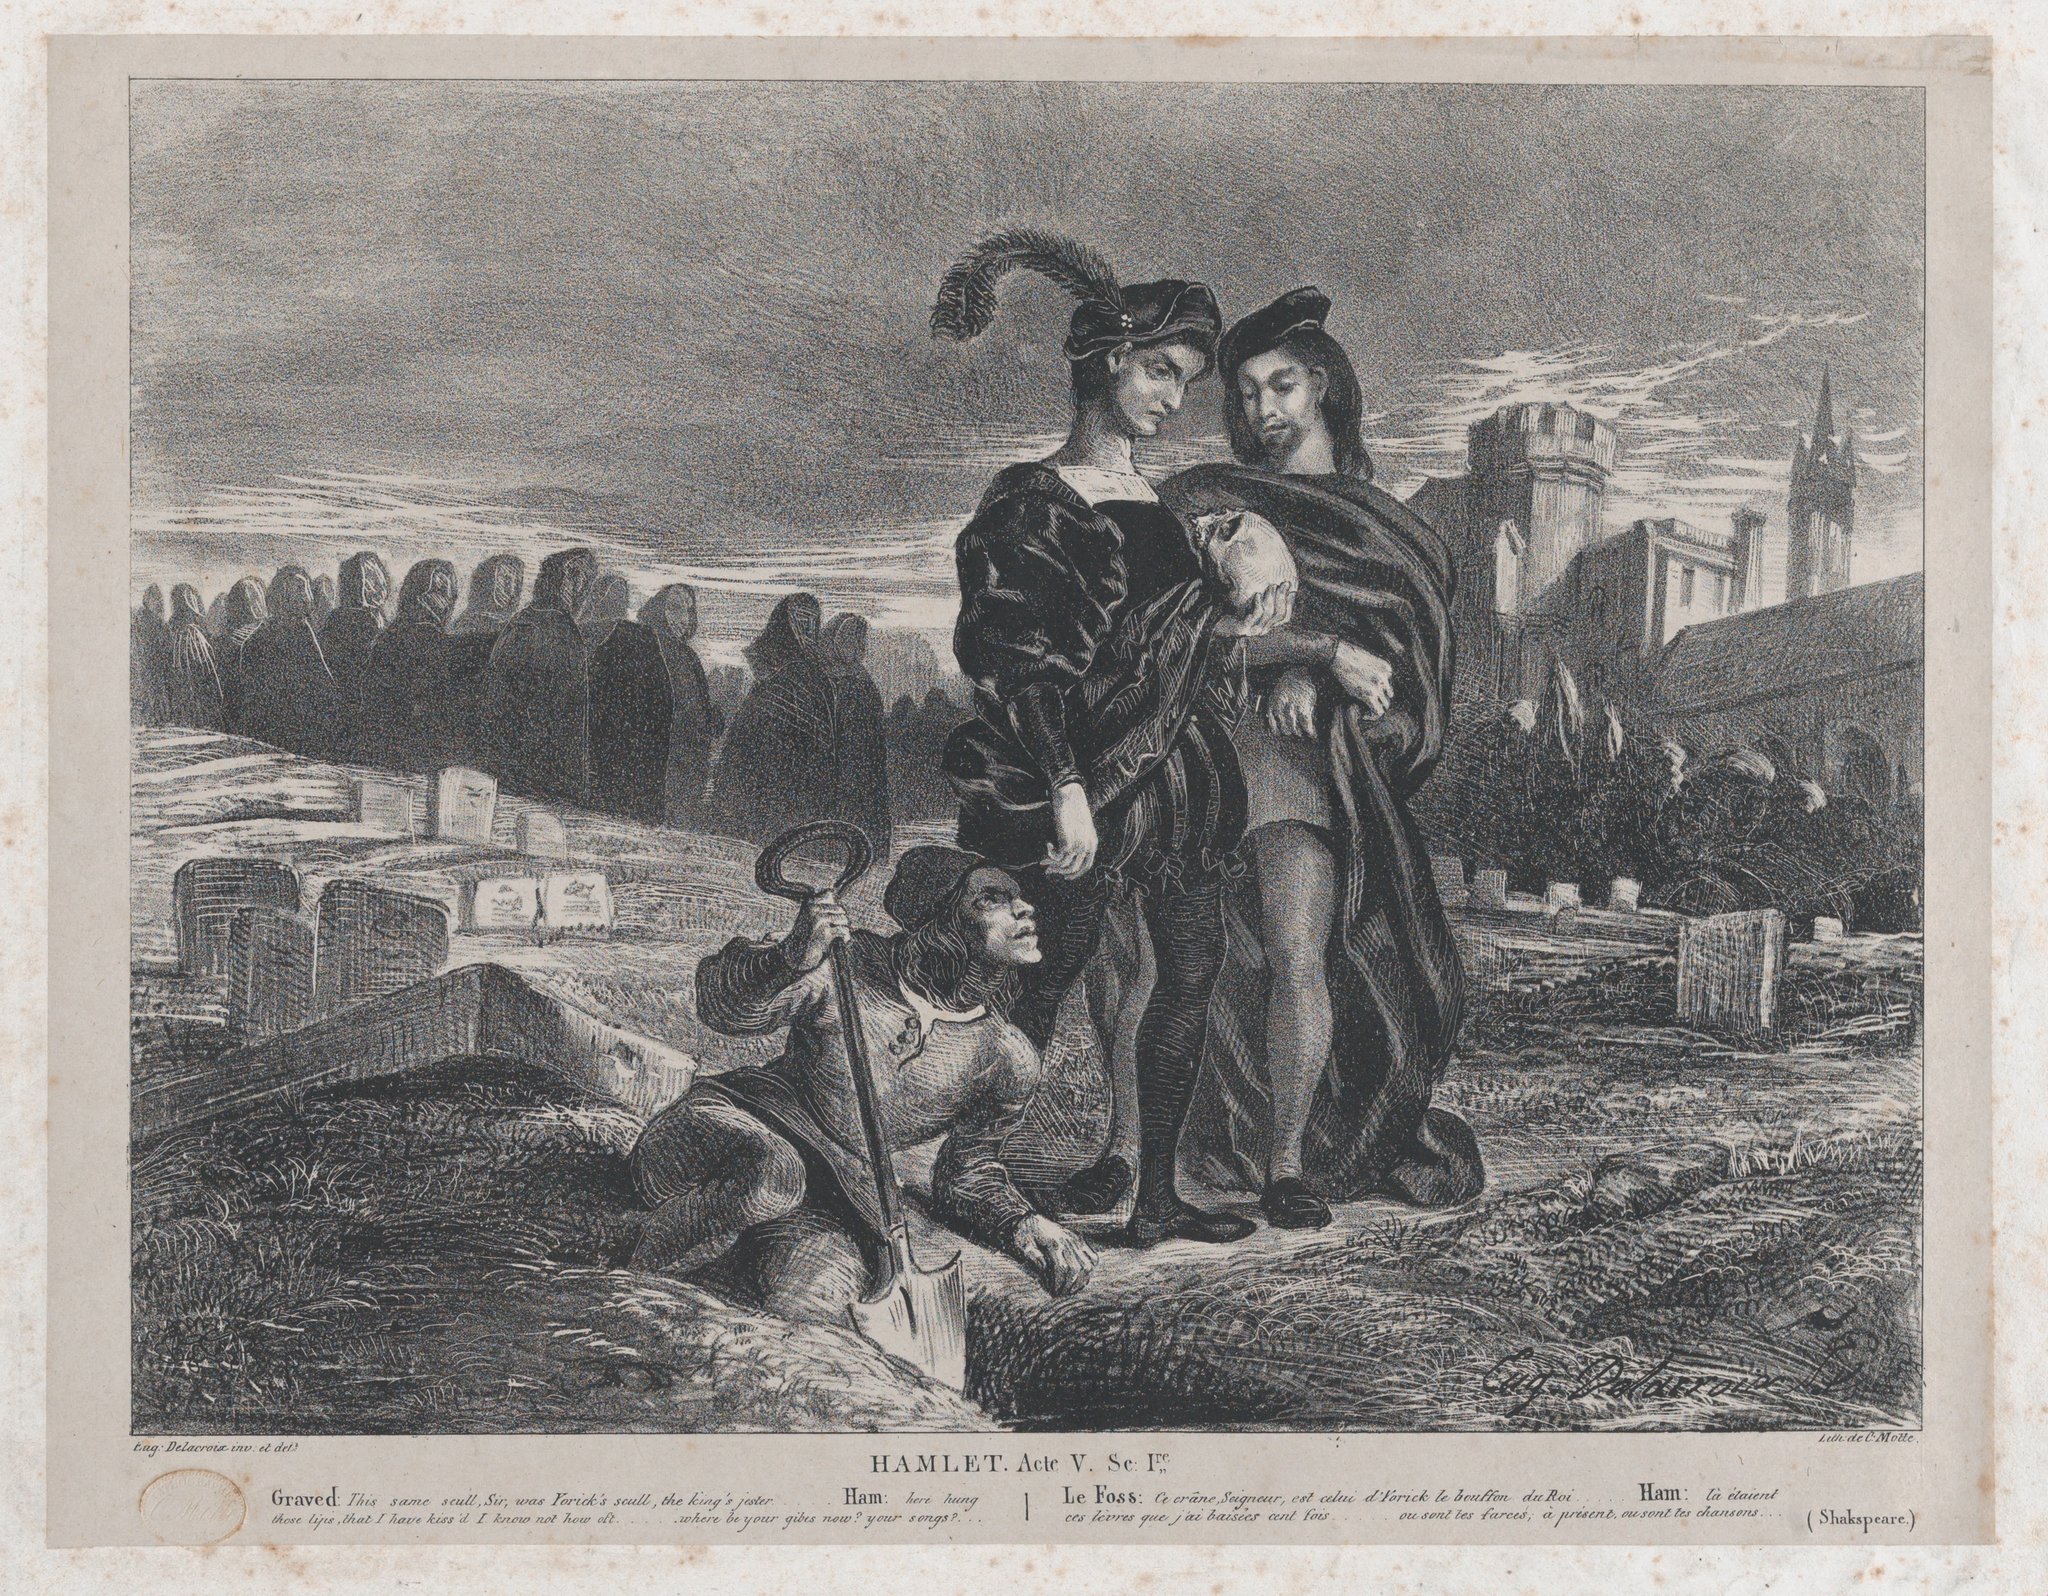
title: Hamlet Contemplating Yorick’s Skull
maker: eugène delacroix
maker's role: artist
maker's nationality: french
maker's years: 1798-1863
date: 1828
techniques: printmaking, lithograph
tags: shakespeare,skulls,men,cemeteries,hamlet